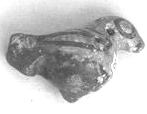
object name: pottery whistle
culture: costa rican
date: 800-1525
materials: pottery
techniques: polychrome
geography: costa rica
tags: birds